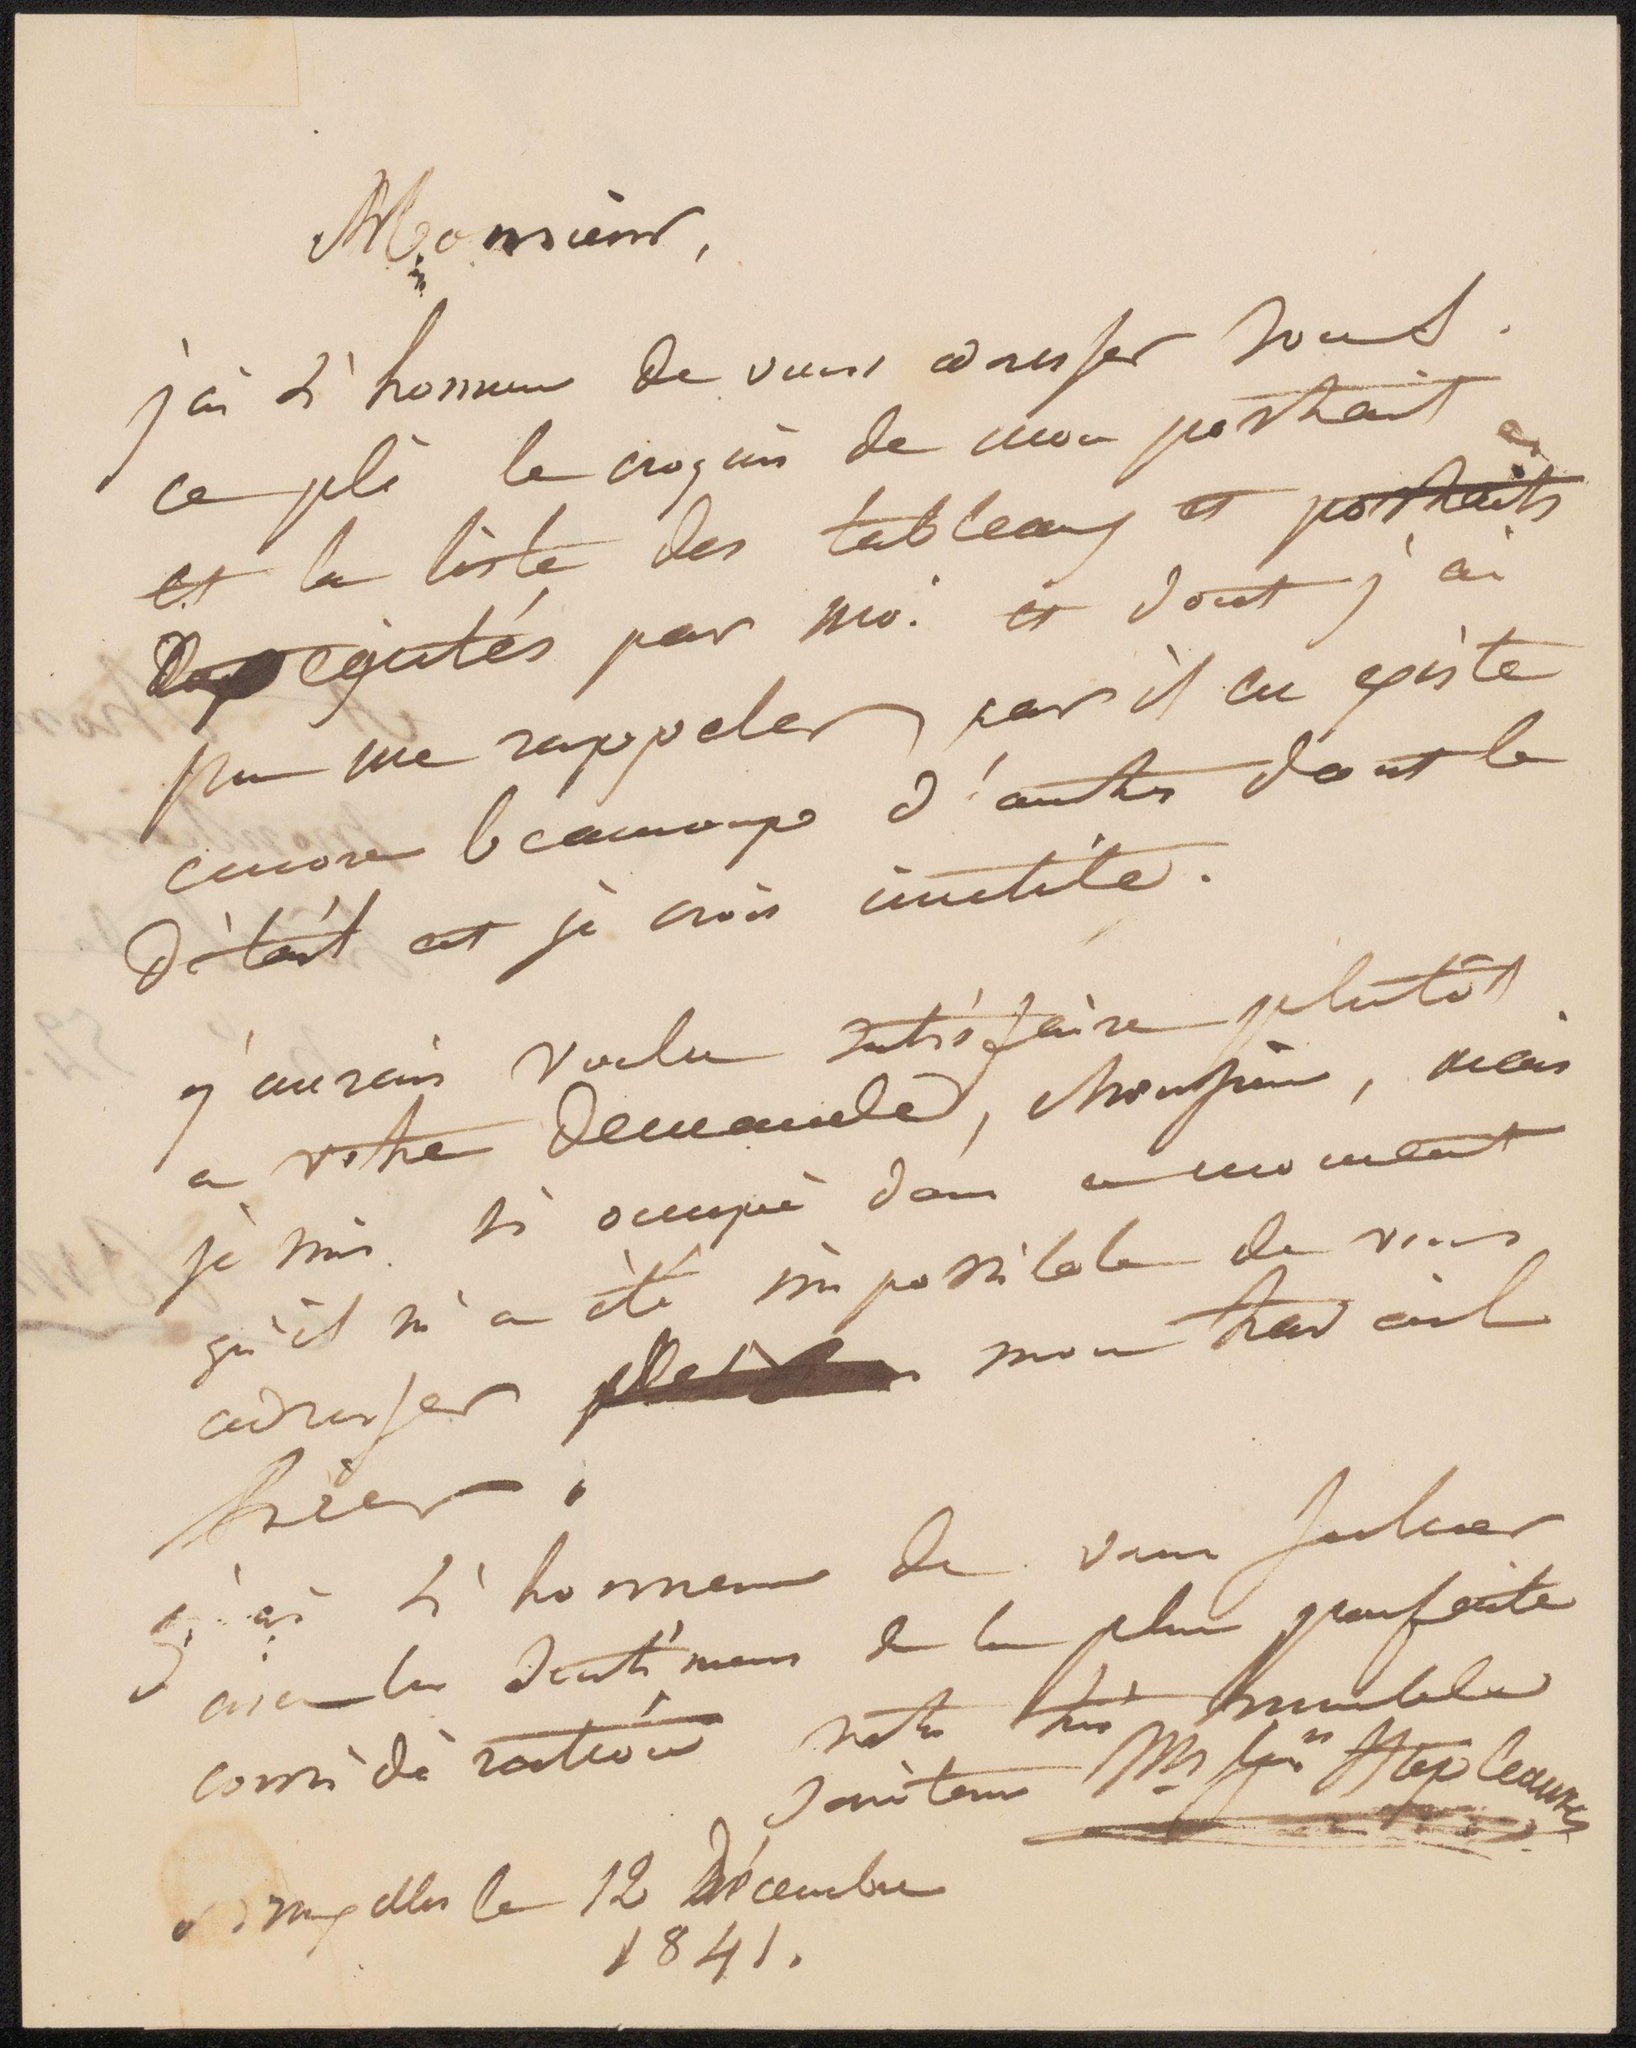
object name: letter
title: Brief aan Johannes Immerzeel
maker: michel ghislain stapleaux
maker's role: painter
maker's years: 1799-1881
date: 1841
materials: ink, paper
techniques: pen, writing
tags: johannes immerzeel, painting (including book-illumination, miniature-painting), historical persons (portraits and scenes from the life)